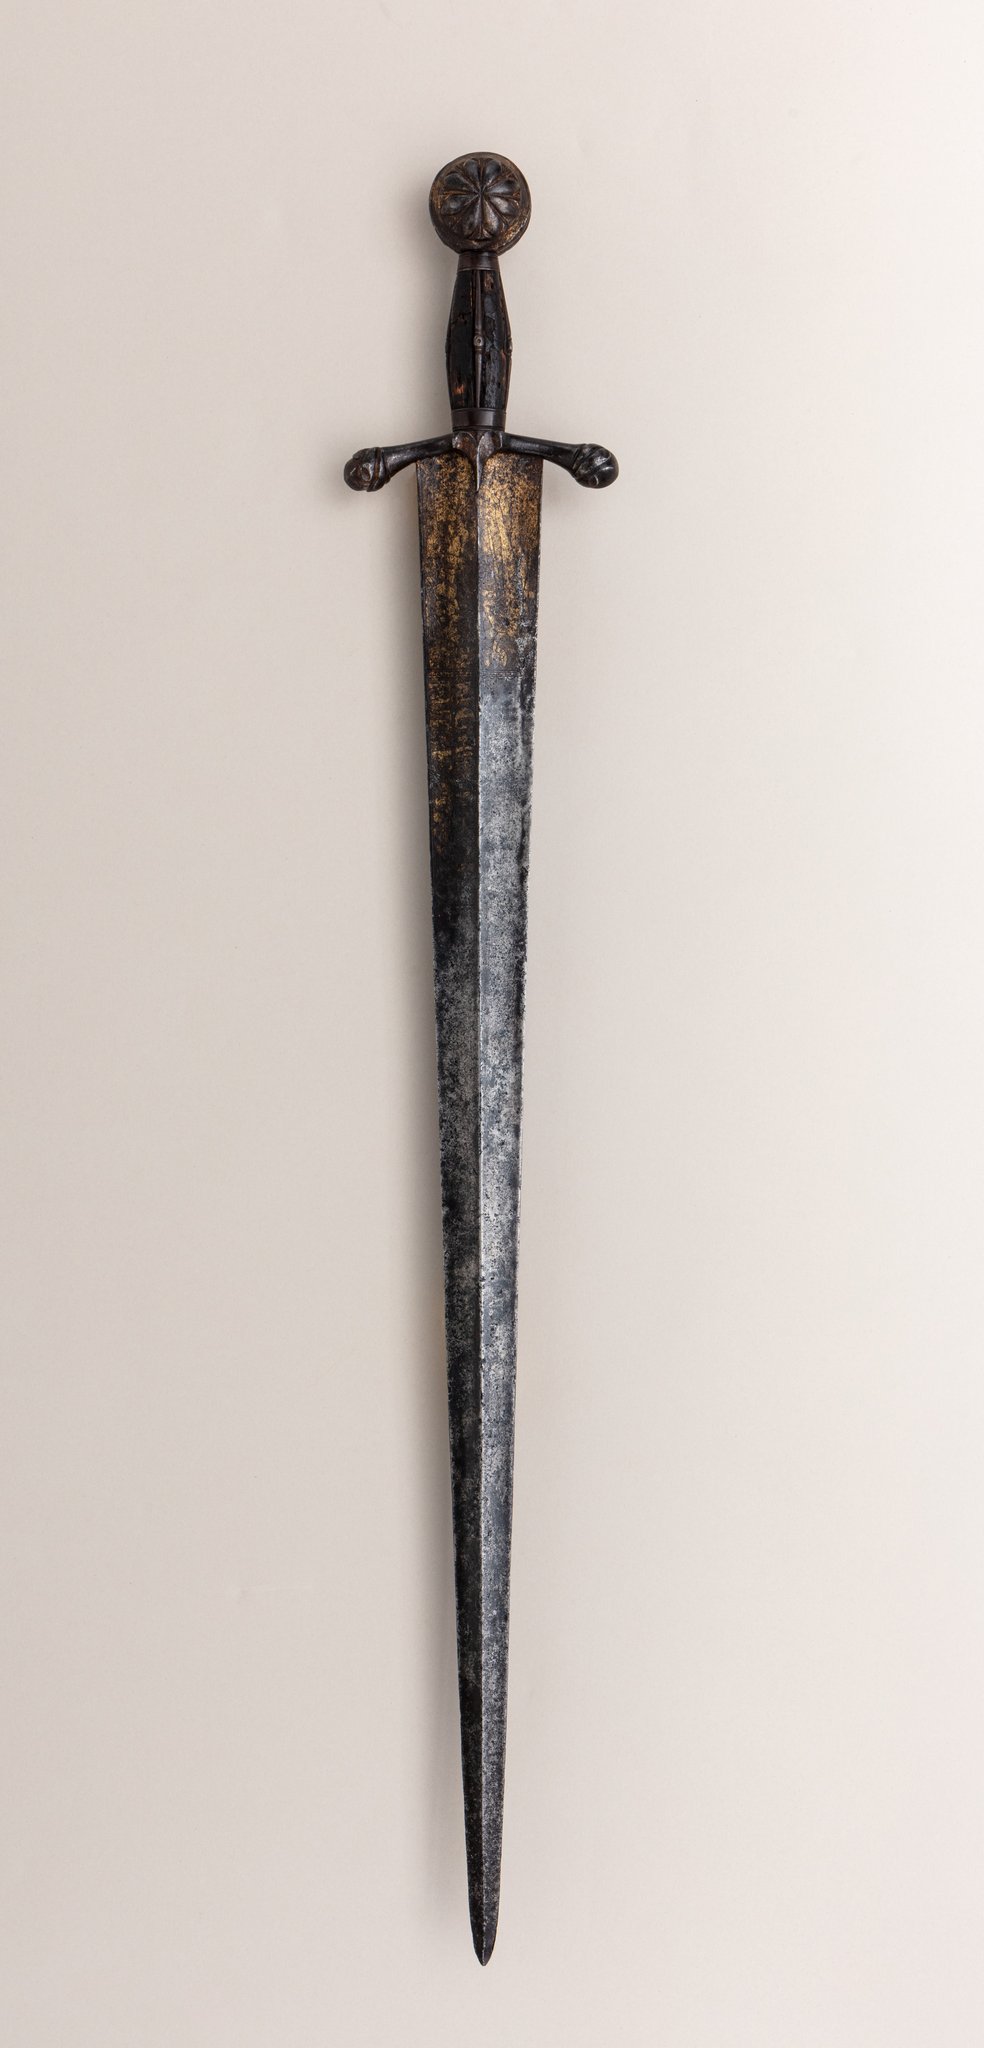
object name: sword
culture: italian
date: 1500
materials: steel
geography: italy